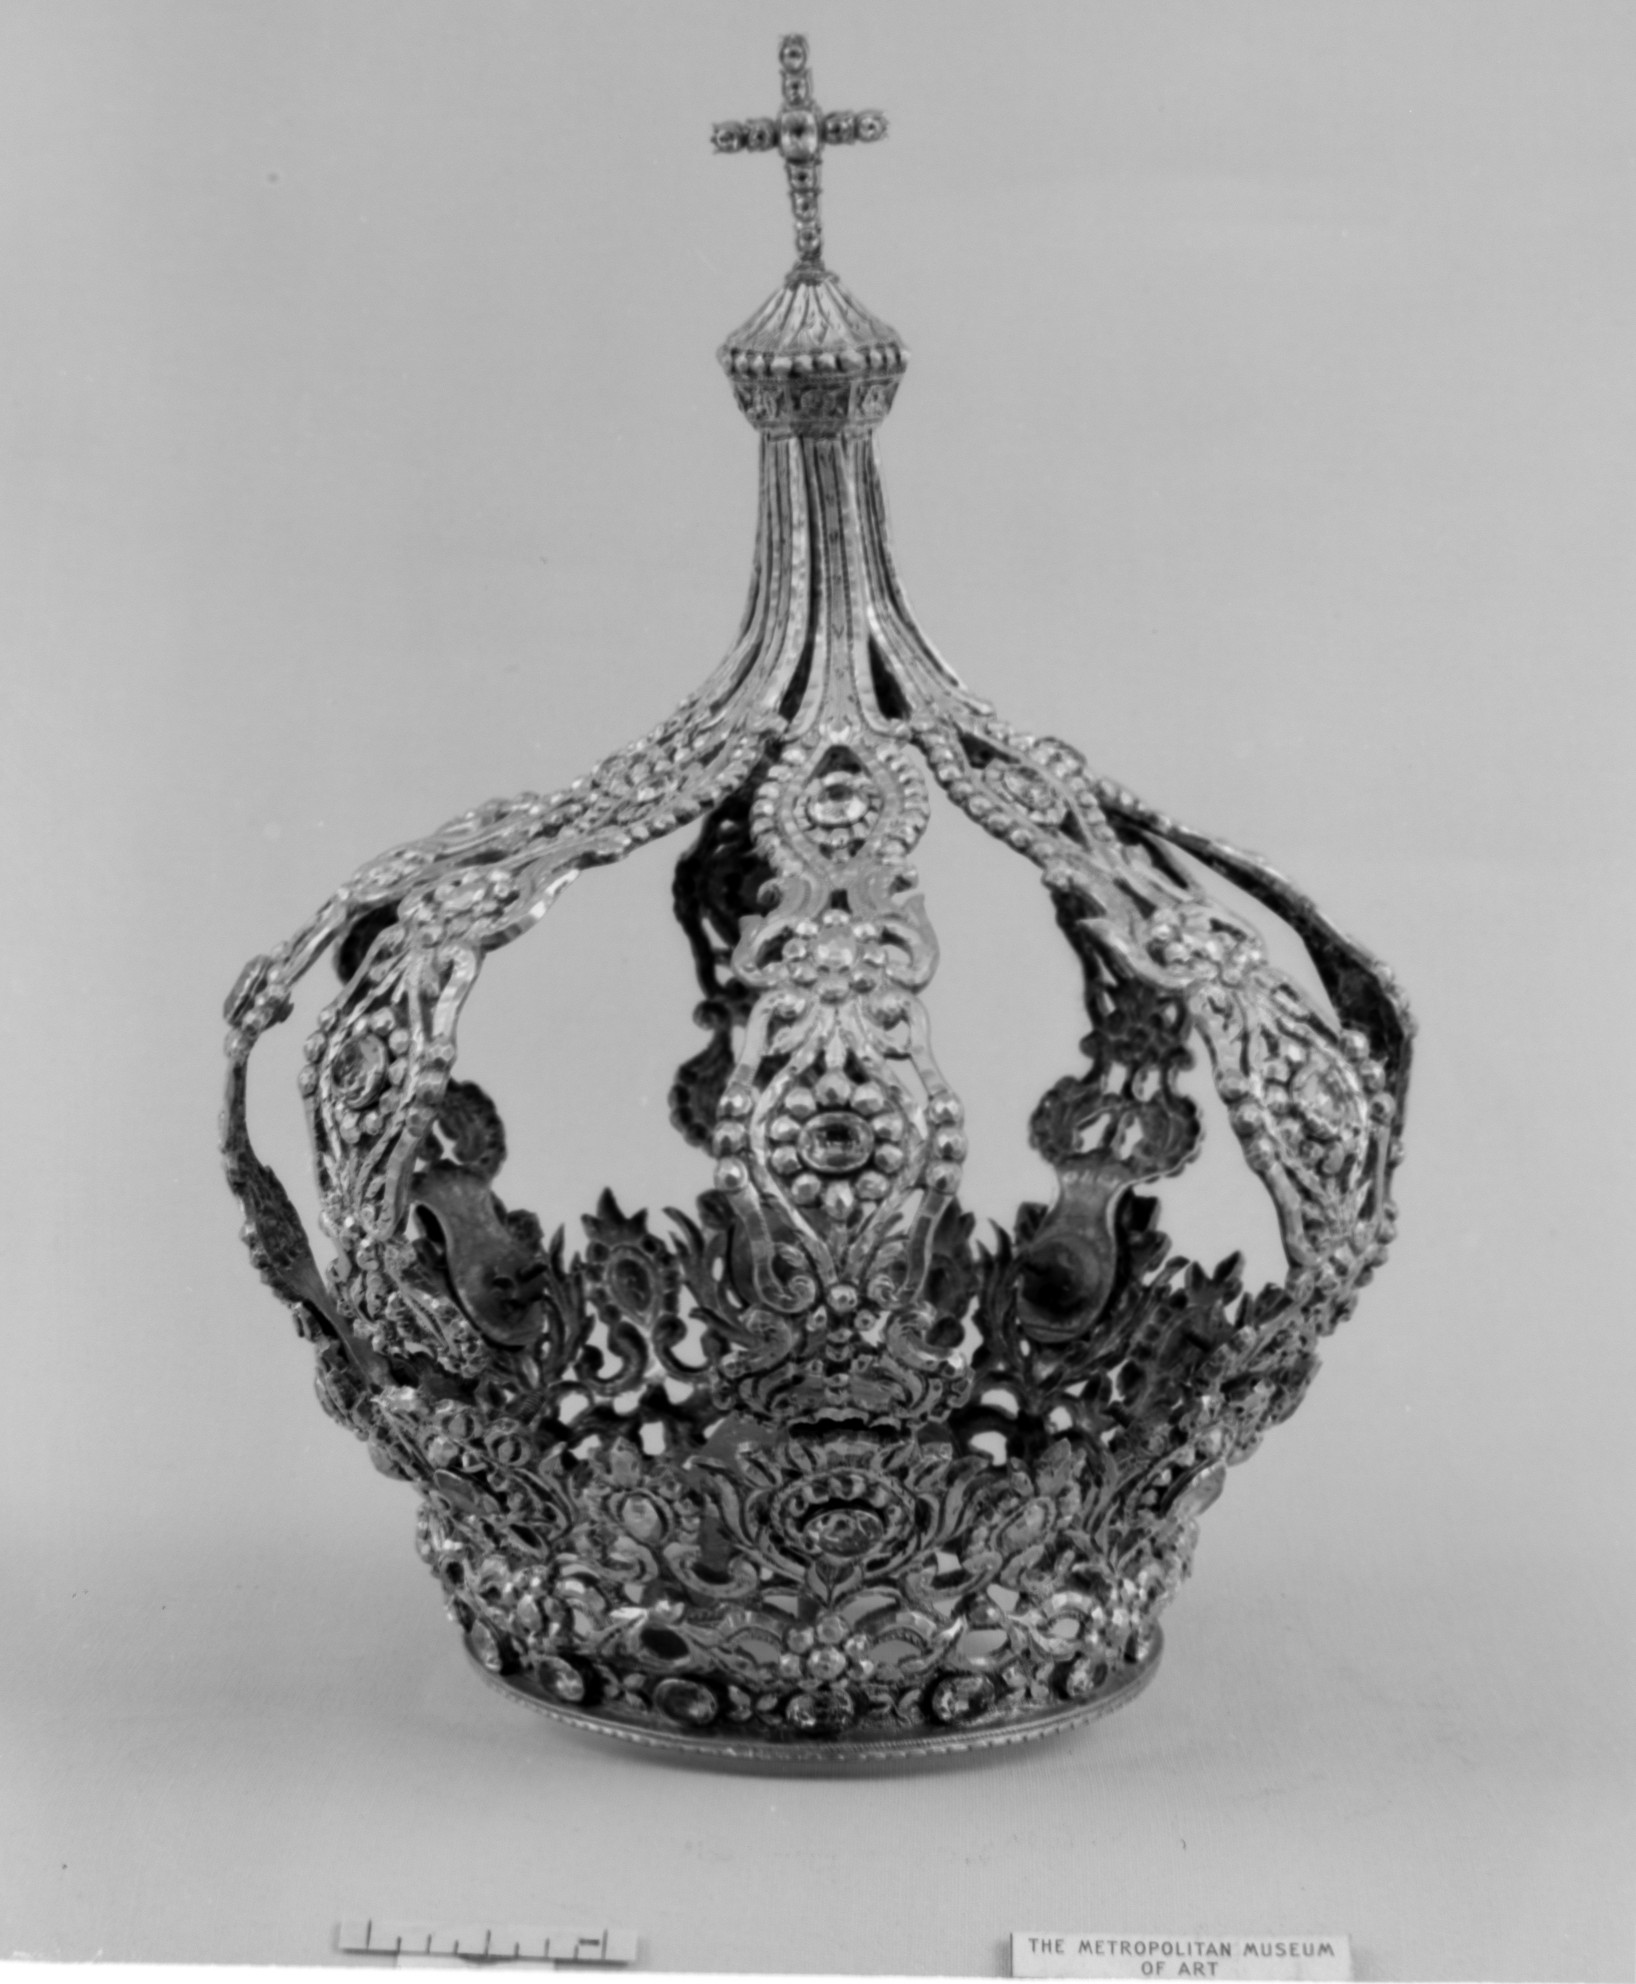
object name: crown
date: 1800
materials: silver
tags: crowns